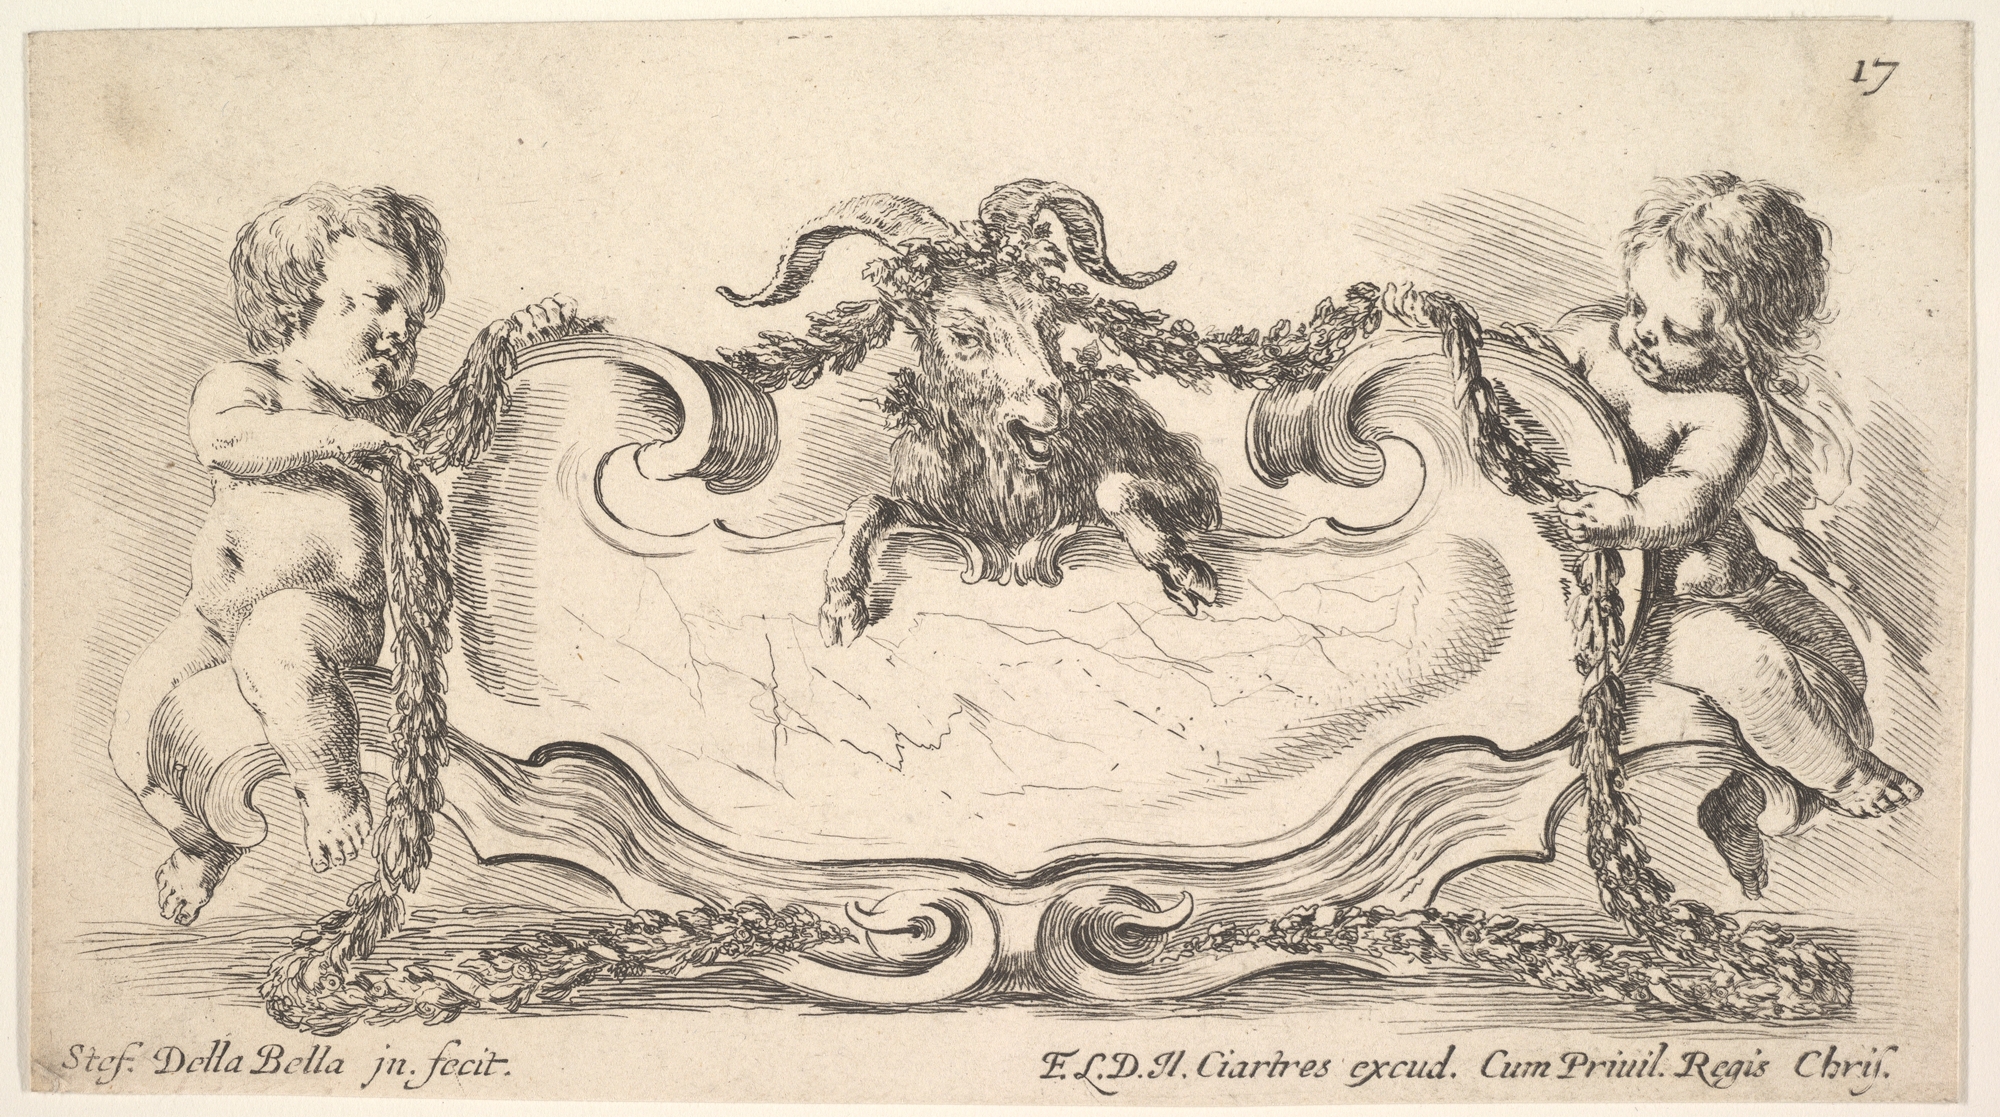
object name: print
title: Plate 17: A cartouche with a marble center, an infant on either side holding a garland over the horns of a ram in center, from "Collection of various caprices and new inventions of cards and ornaments" (Raccolta di varii cappriccii et nove inventioni di cartelle et ornamenti)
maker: stefano della bella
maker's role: artist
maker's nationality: italian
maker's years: 1610-1664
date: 1646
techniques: etching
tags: cartouches,garlands,infants,rams